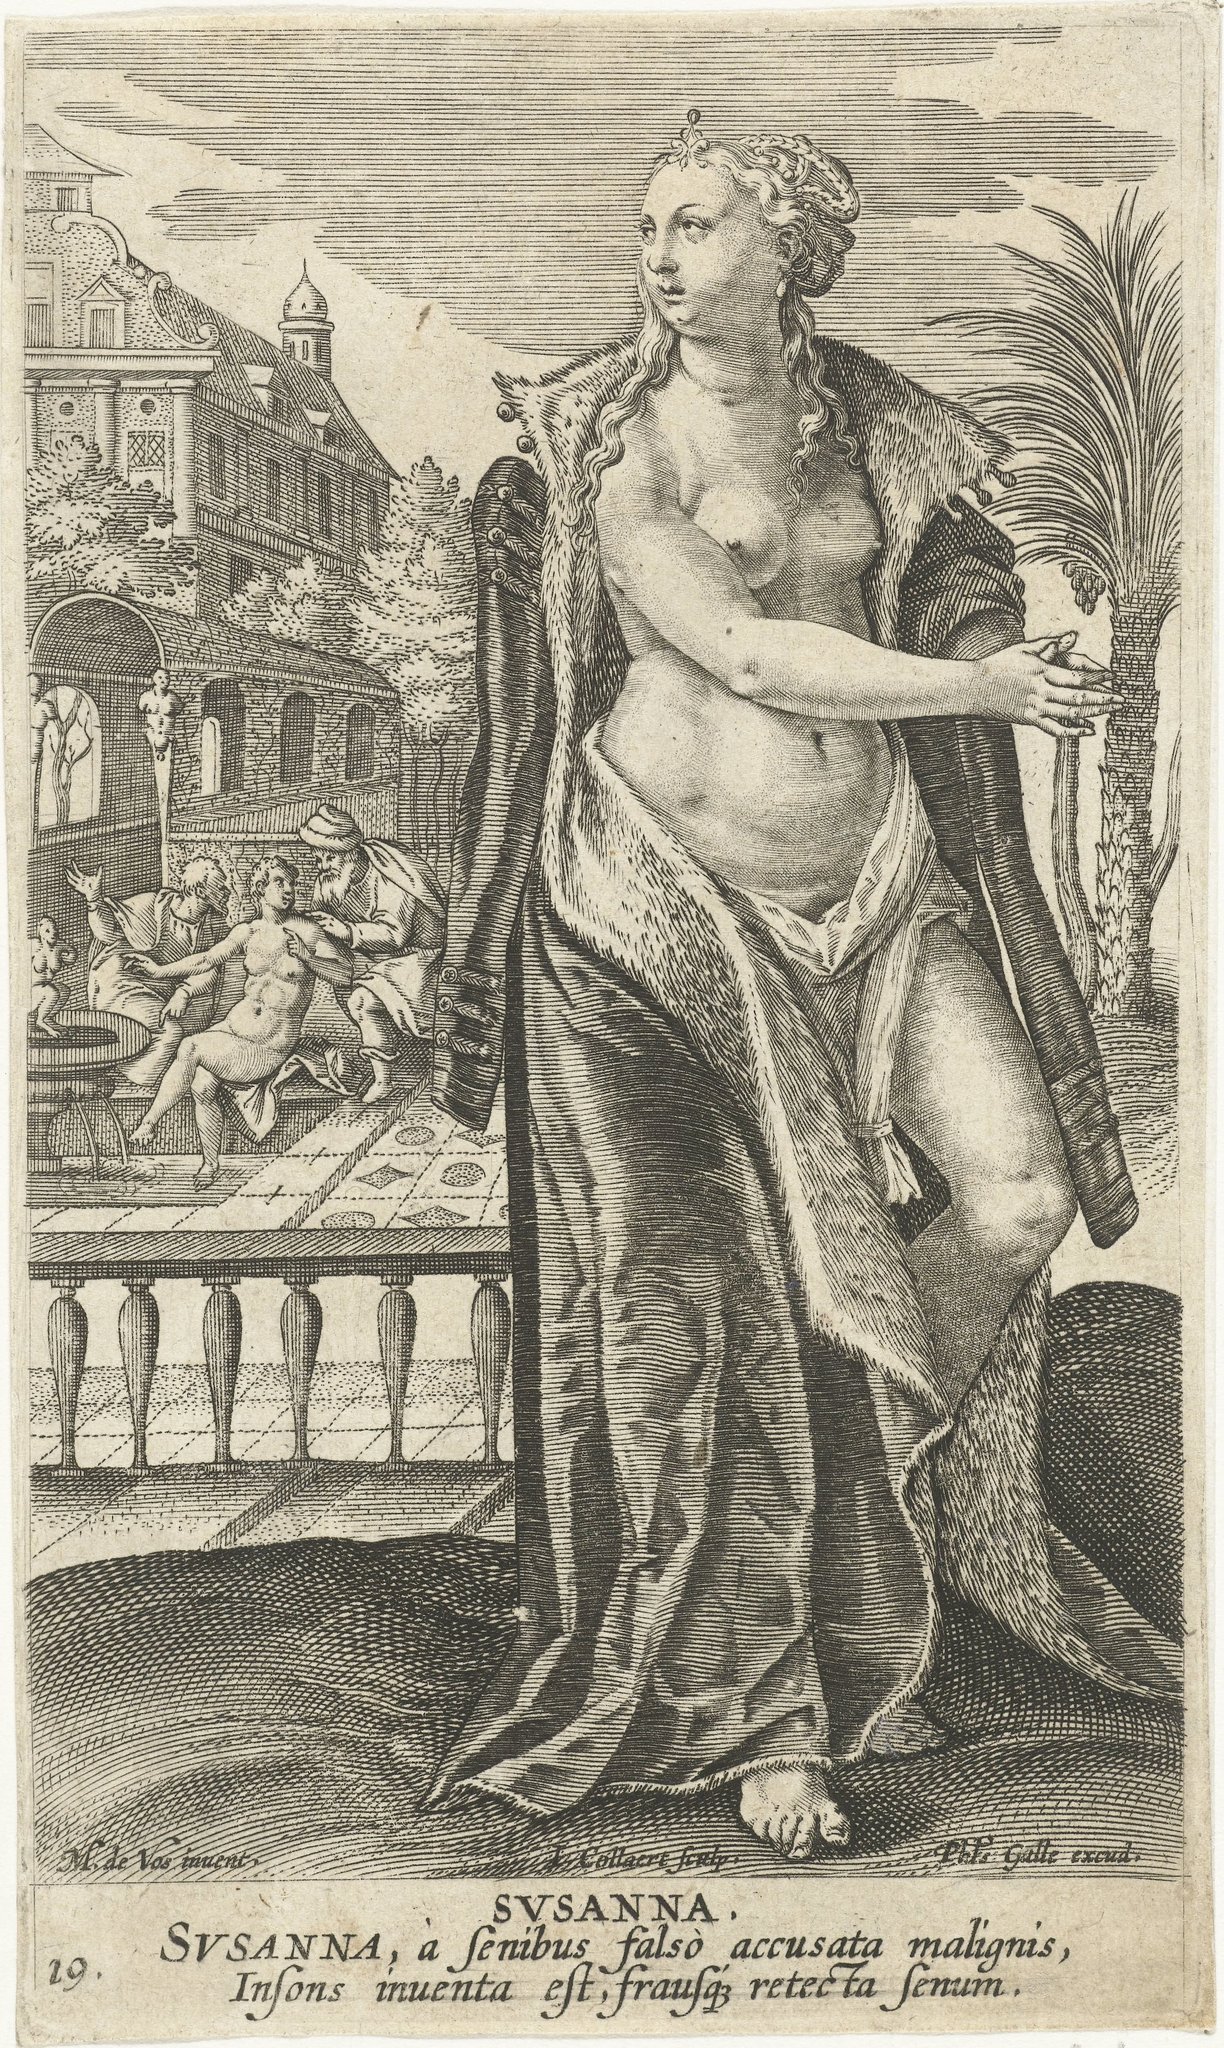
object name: print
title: Beroemde vrouwen uit het Oude Testament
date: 1588-1597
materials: paper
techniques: engraving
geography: antwerp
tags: the elders making advances towards susanna, female persons from the old testament (with name) (not in biblical context)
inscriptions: collector's mark: Lugt 2228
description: Op de voorgrond de half-naakte Susanna. Op de achtergrond wordt ze tijdens het baden lastig gevallen door de twee ouderlingen. De prent heeft een Latijns onderschrift en maakt deel uit van een prentserie met beroemde vrouwen uit het Oude Testament.